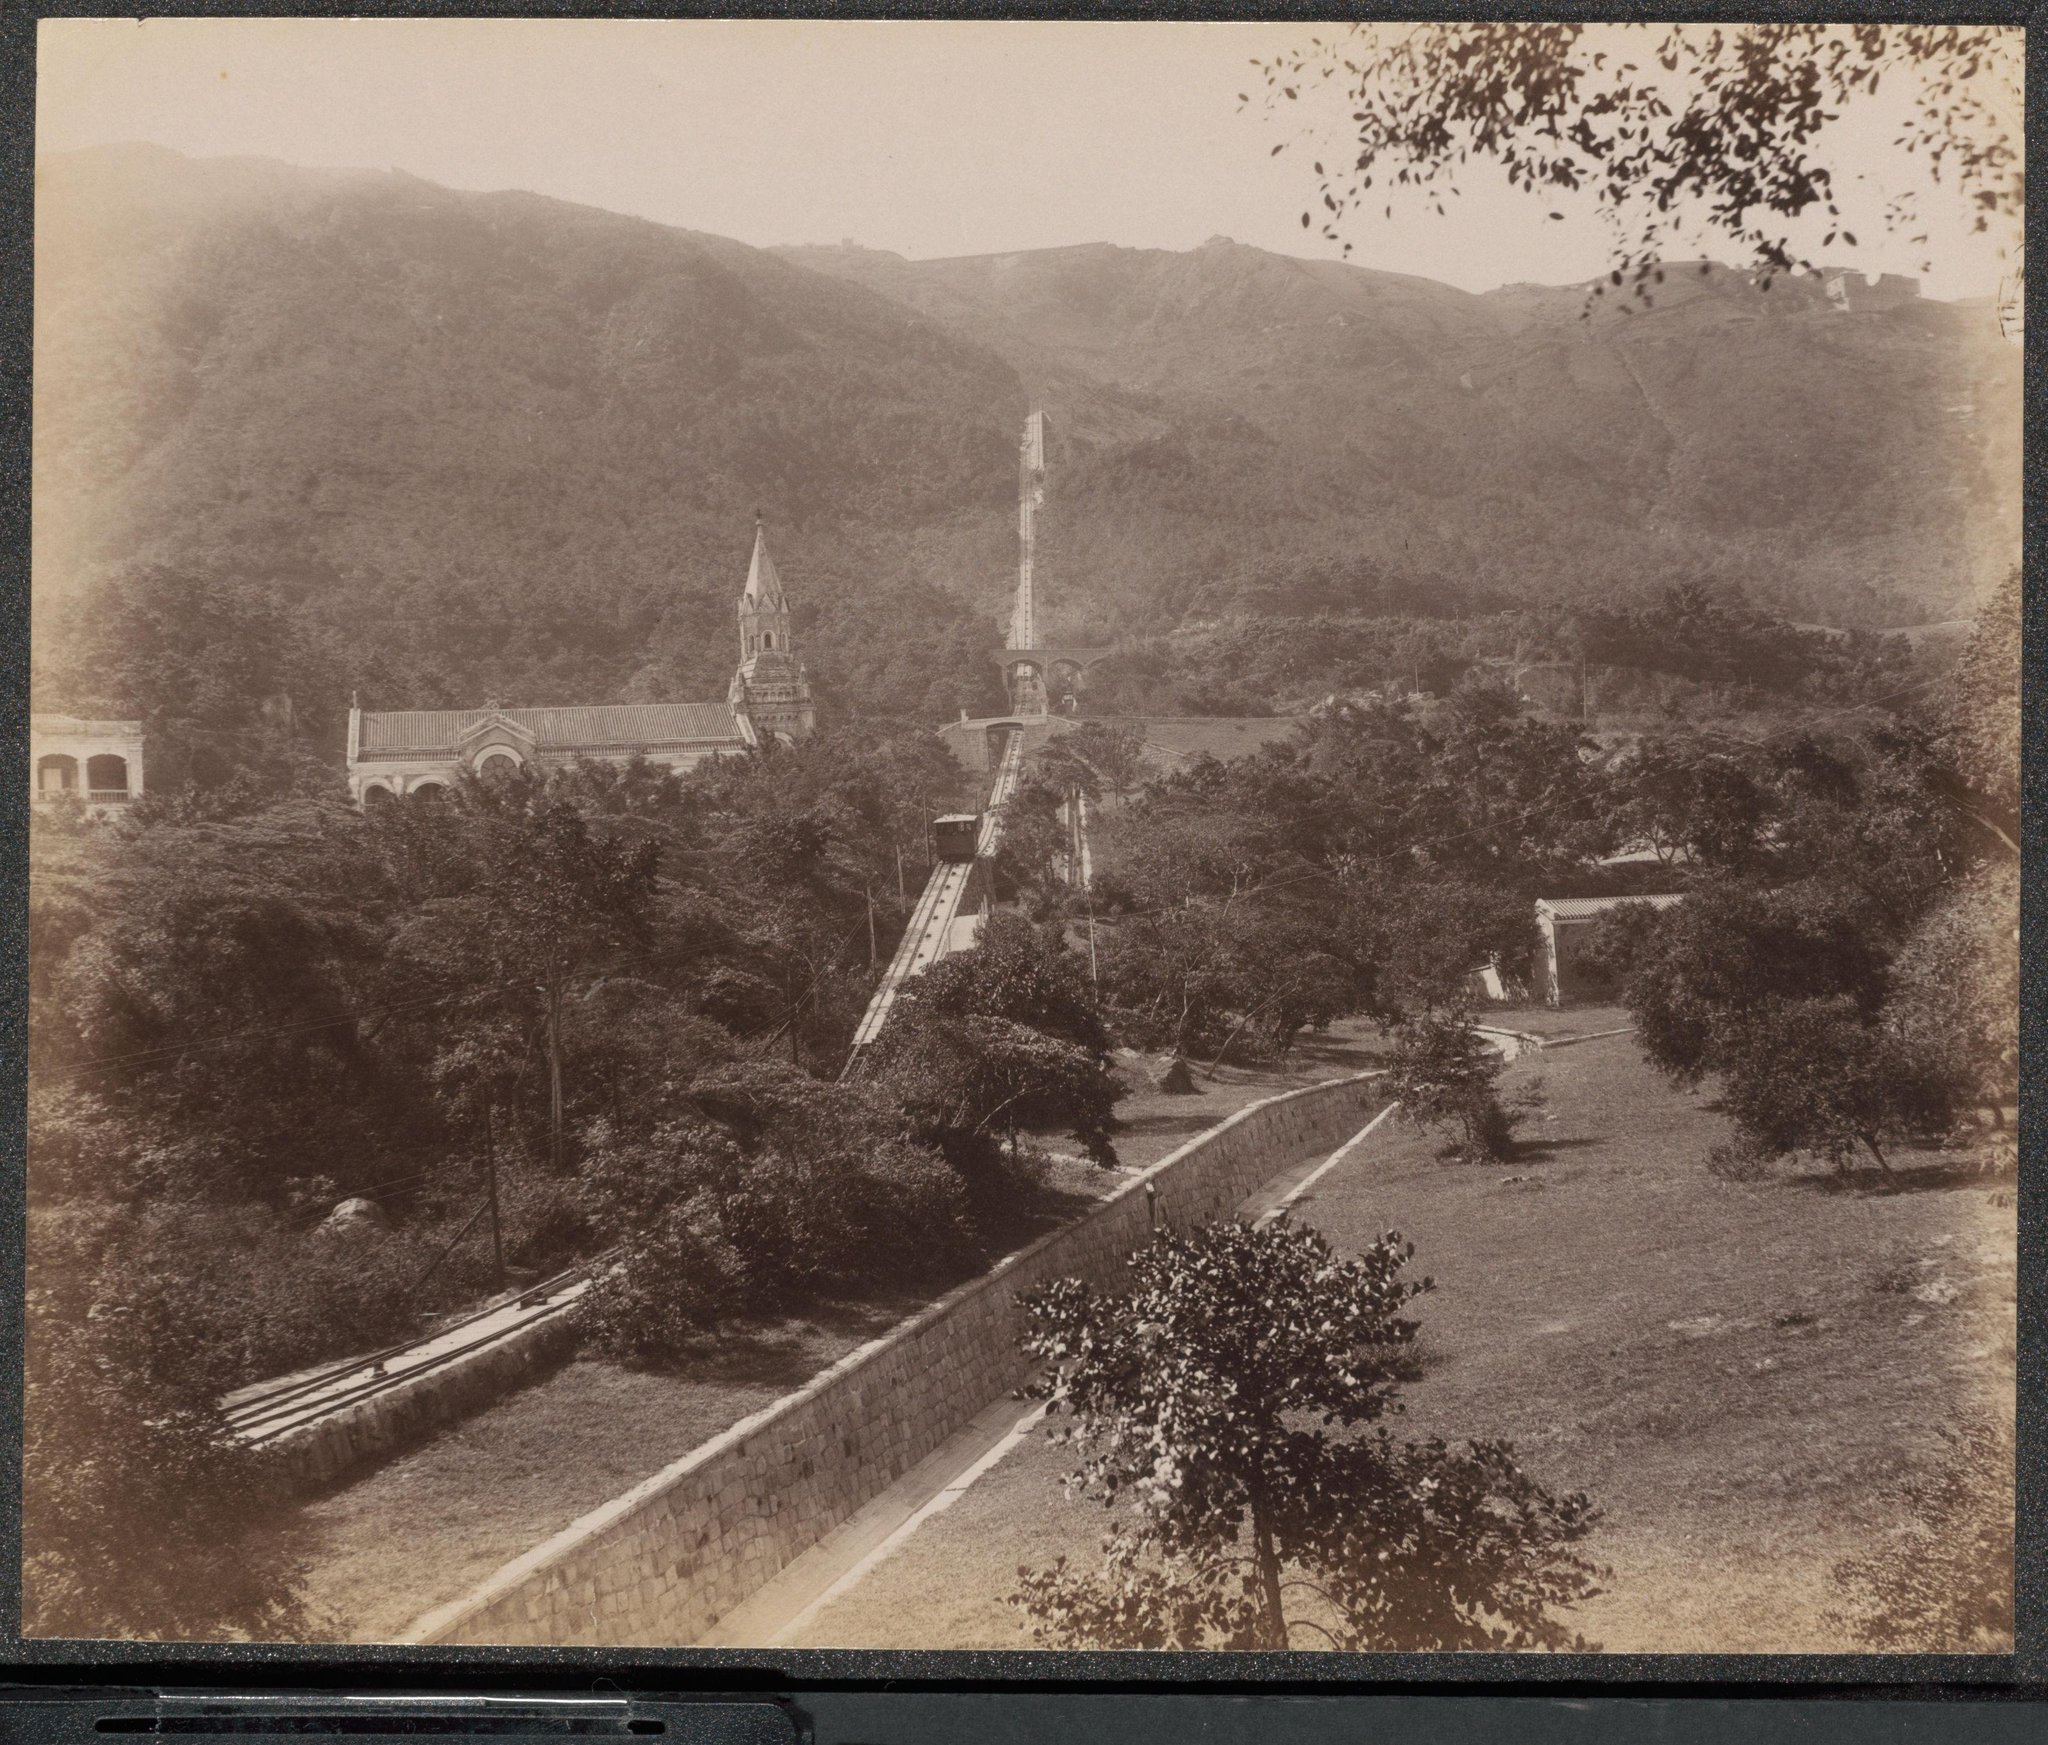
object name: photograph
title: Gezicht op een kerk en een tandradspoorweg op The Peak (Mount Austin) in Hong Kong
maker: Anonymous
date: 1860-1900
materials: paper, photographic support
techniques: albumen print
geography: hong kong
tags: railway, train, mountains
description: Onderdeel van Album met 50 foto's van een reis door Zuidoost-Azië.